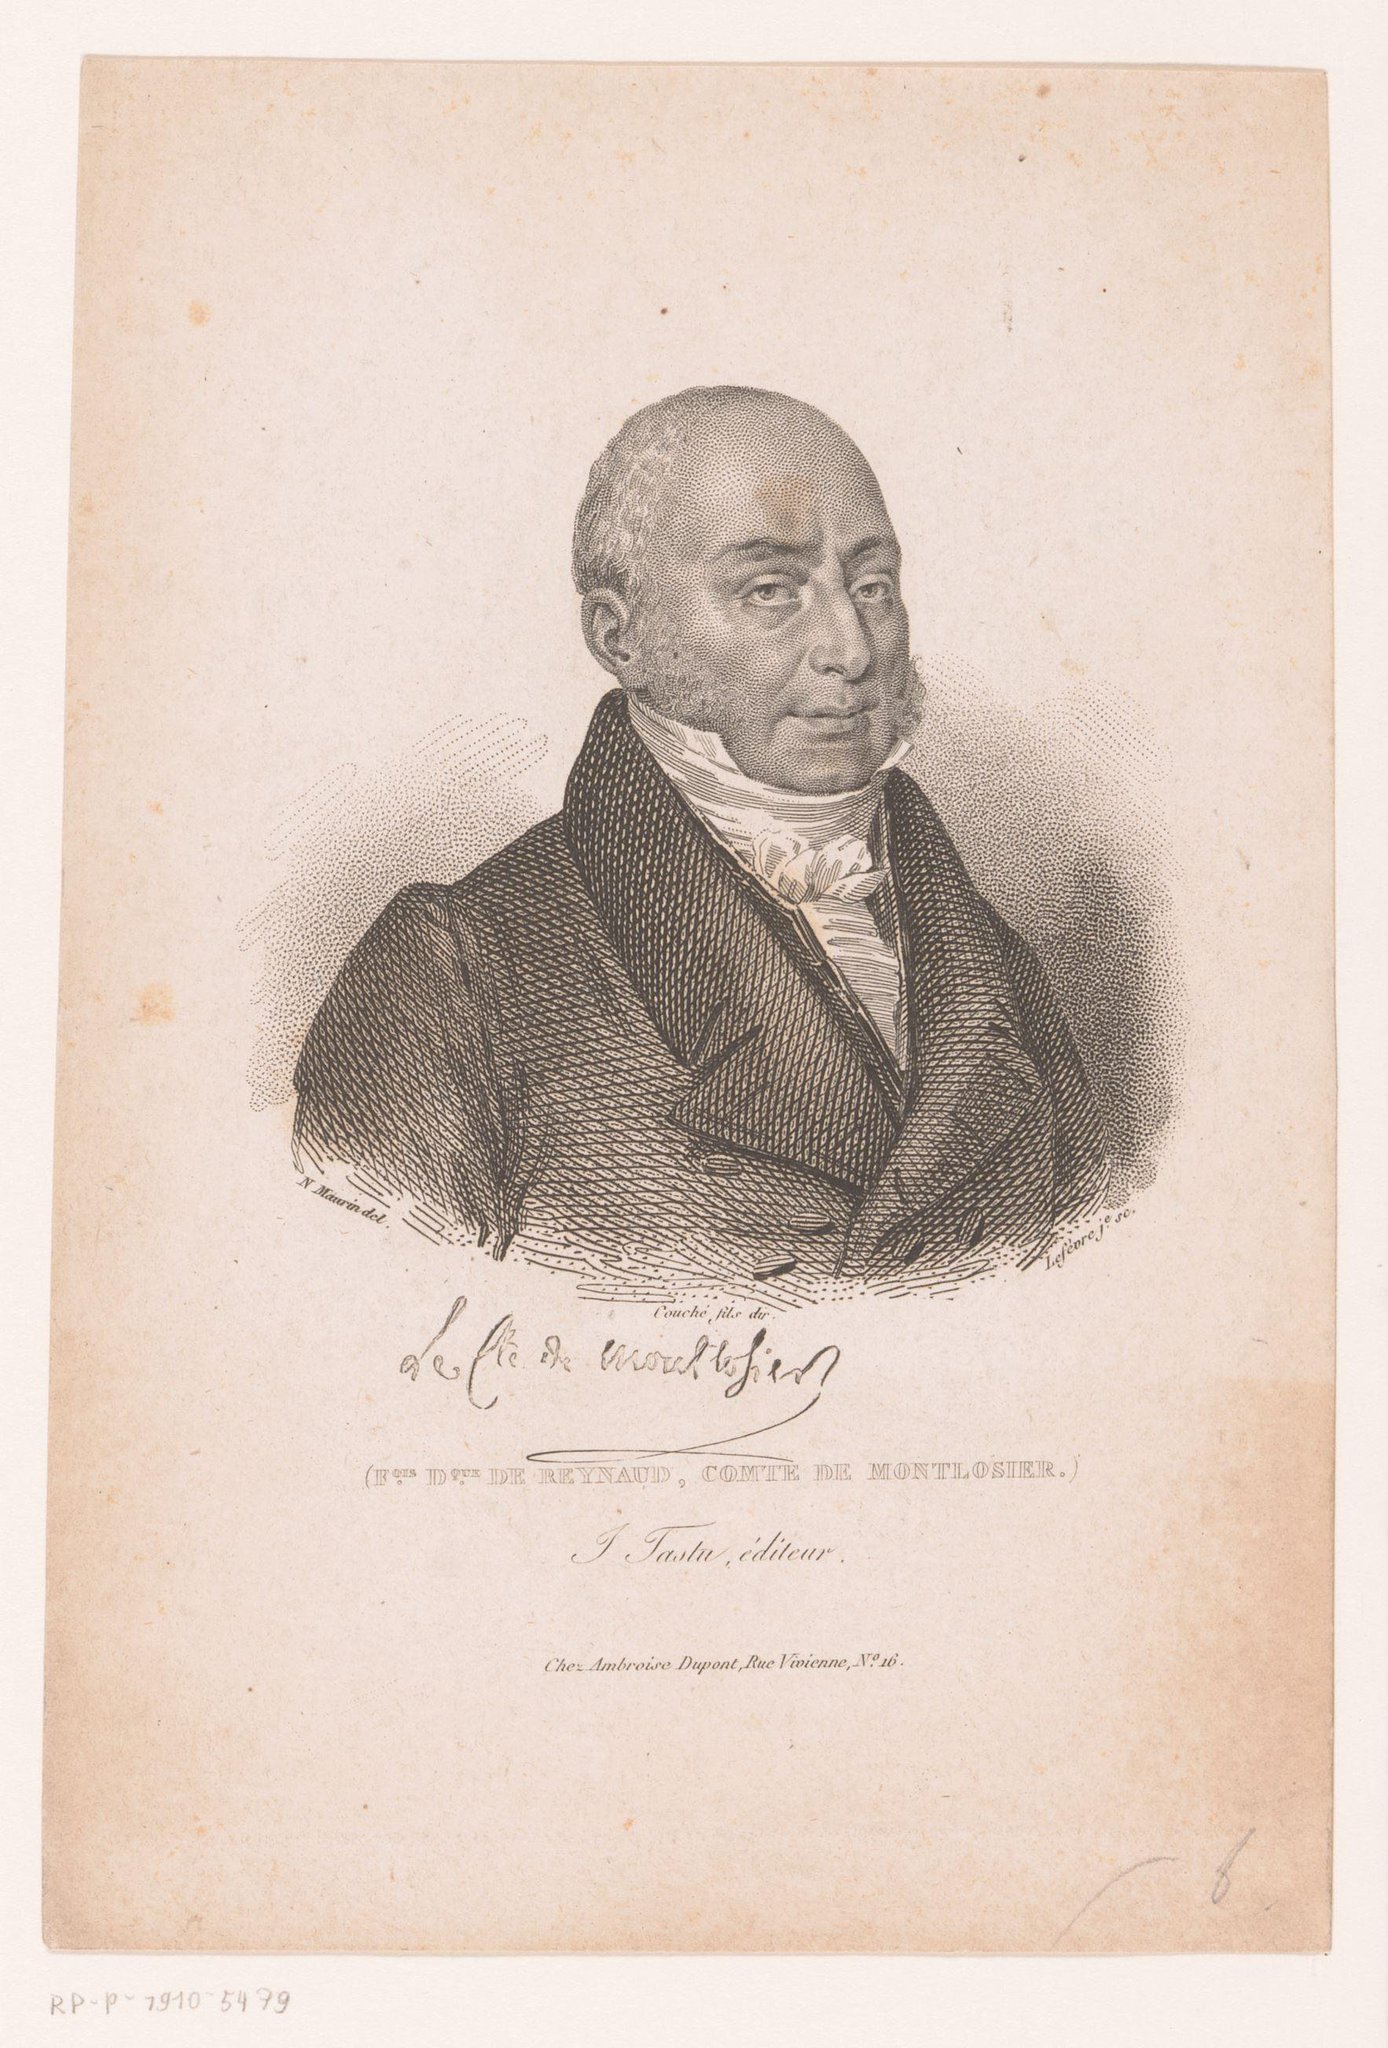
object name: print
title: Portret van François Dominique de Reynaud, hertog van Montlosier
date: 1808-1849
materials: paper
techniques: engraving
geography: paris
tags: historical persons, politician, e.g. party leader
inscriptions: collector's mark: Lugt 2228